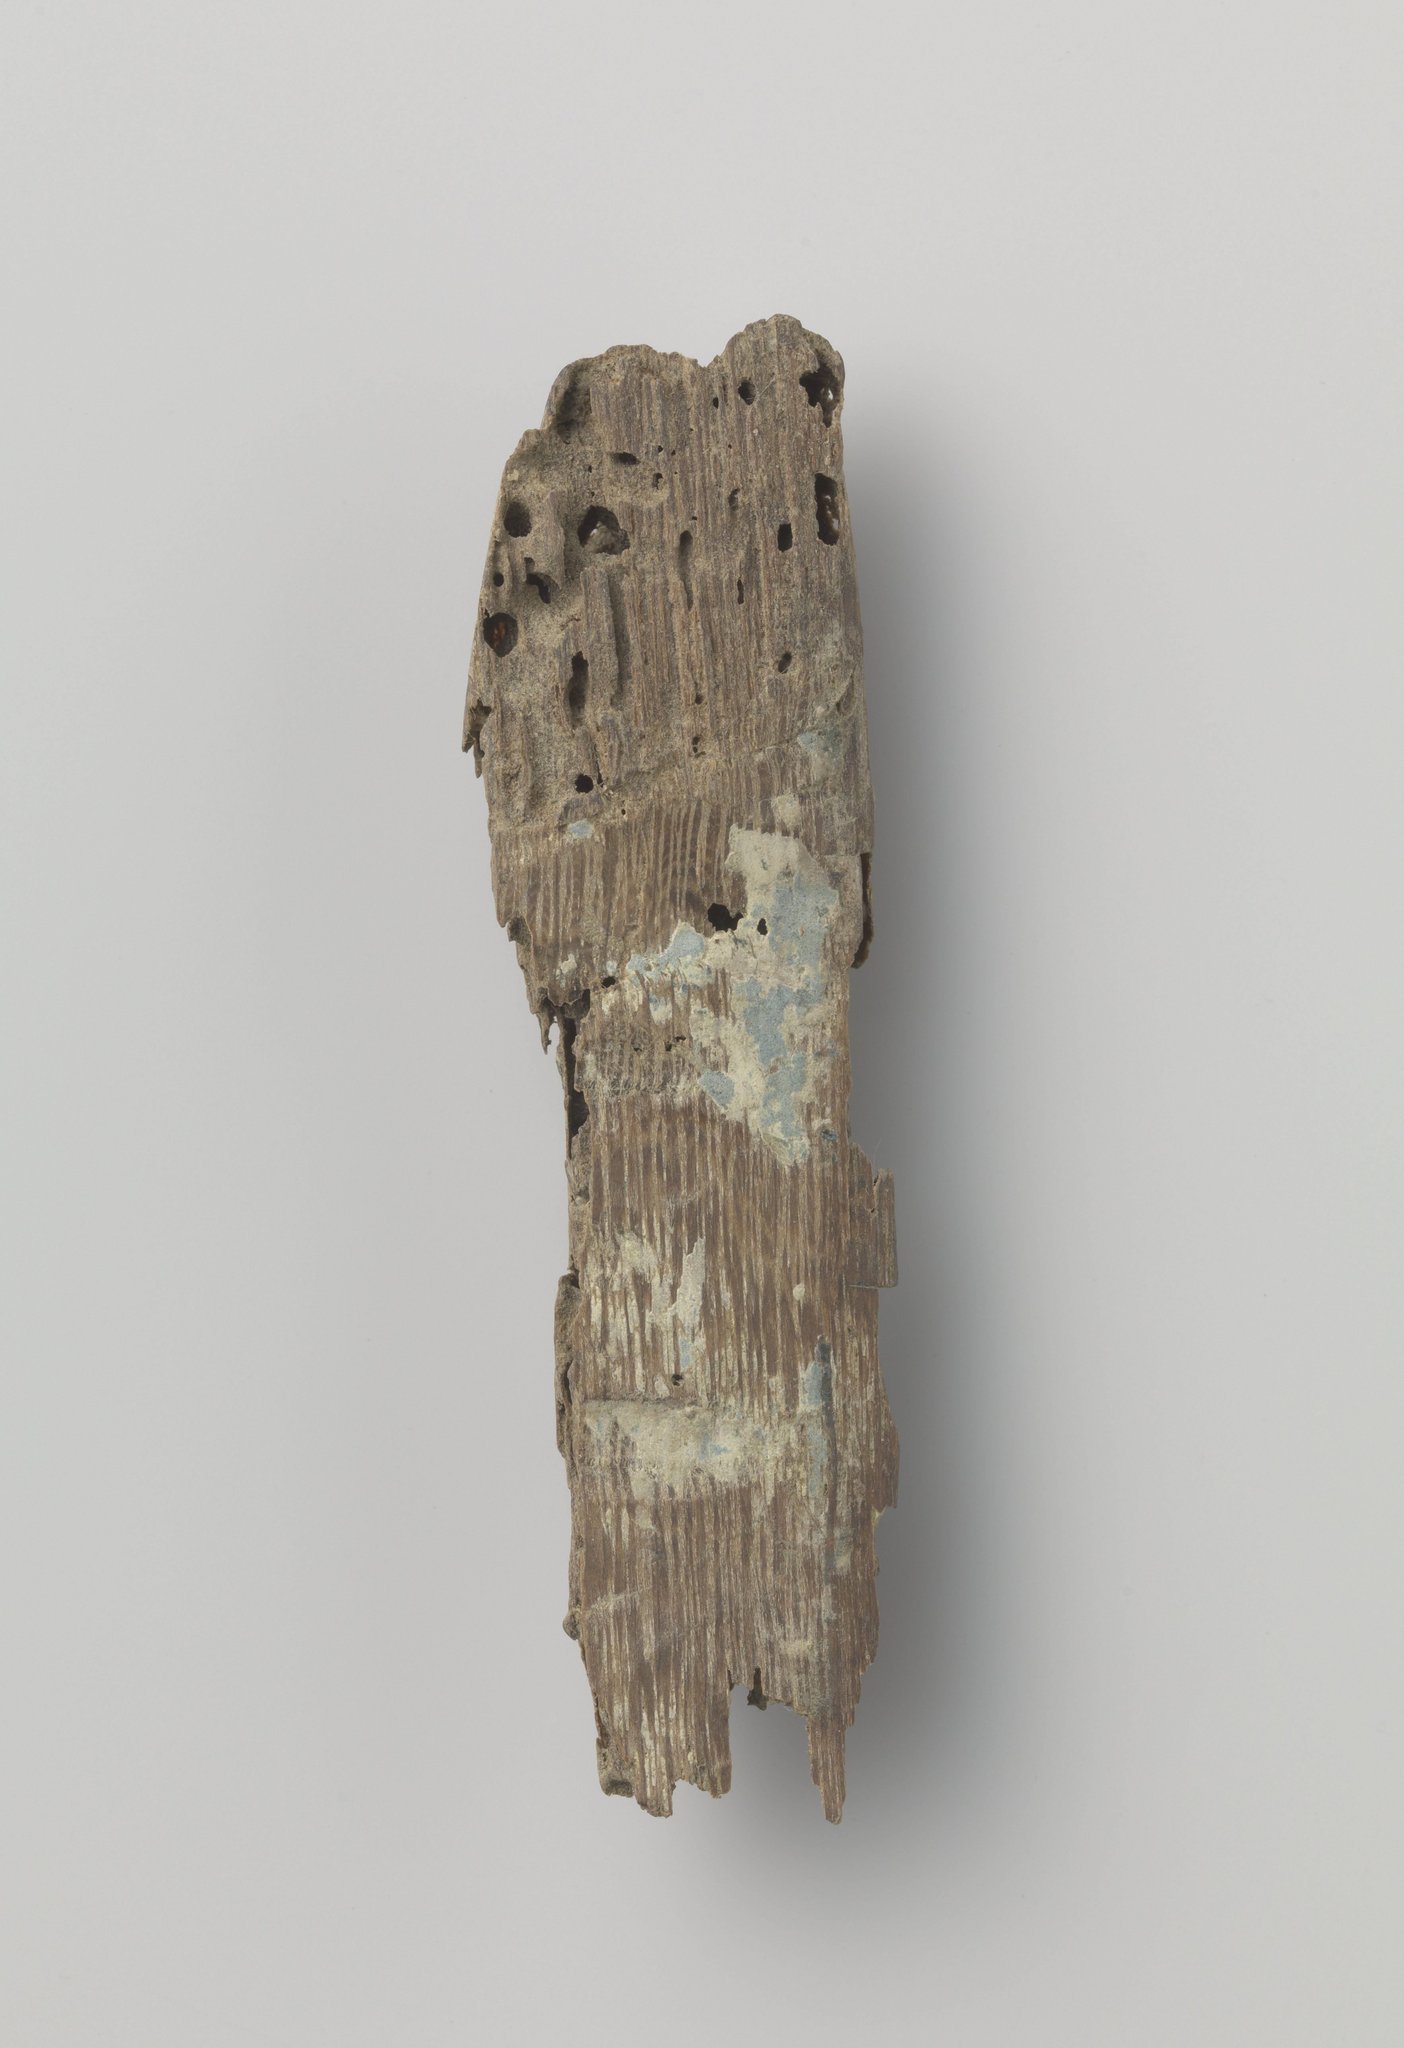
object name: fragment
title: Fragment; (mogelijk) behorend tot het retabel van Soest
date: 1475-1499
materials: wood